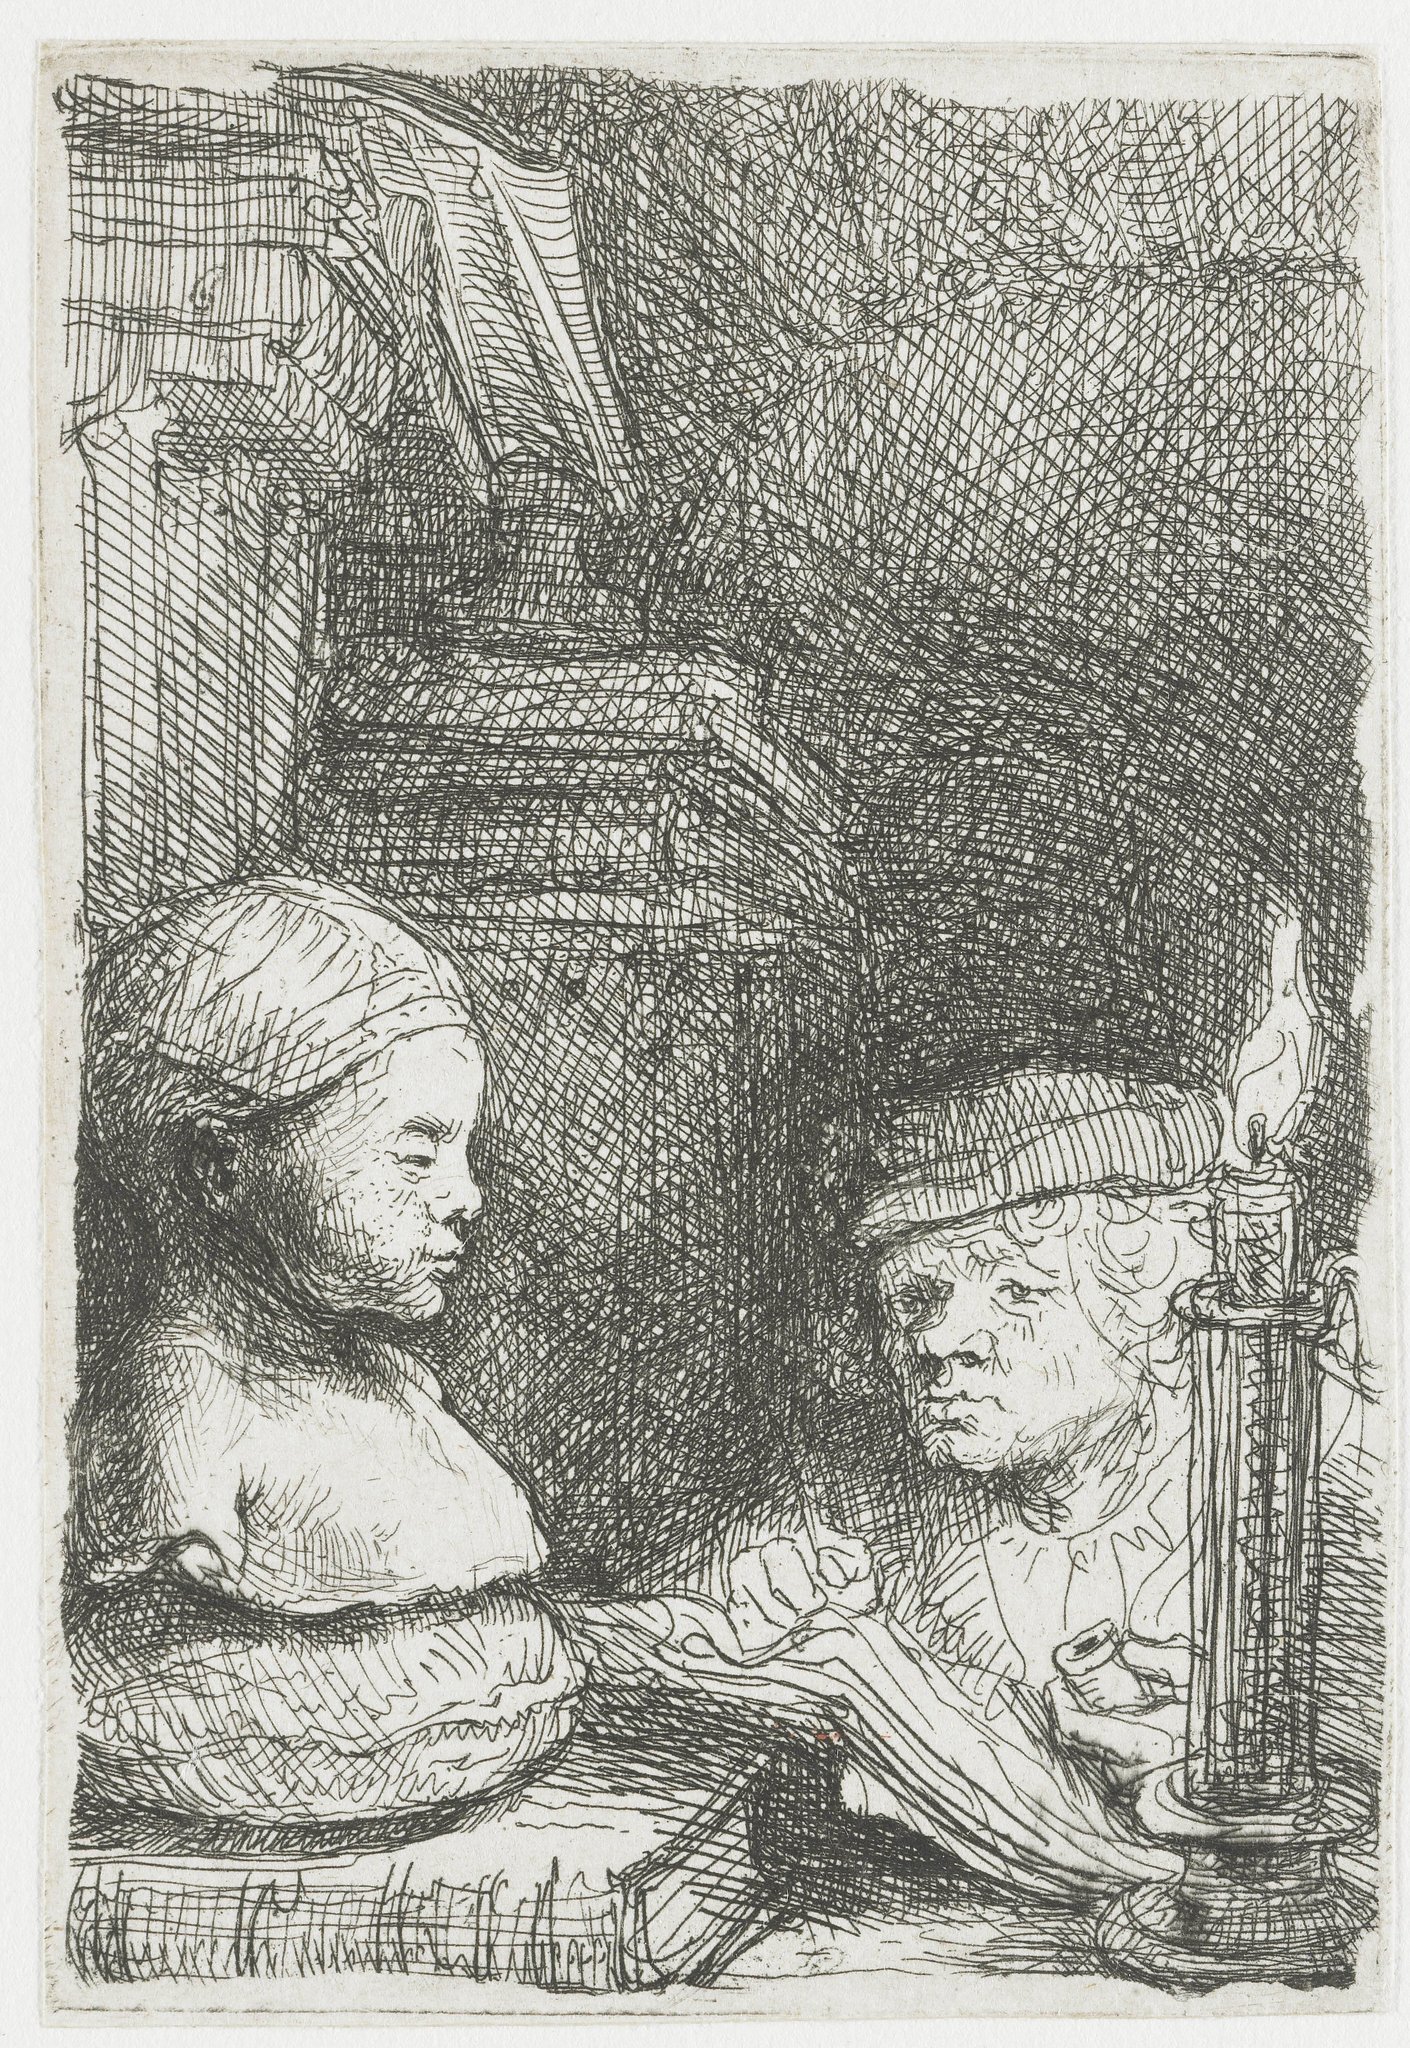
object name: print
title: Man Drawing from a Plaster Cast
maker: rembrandt van rijn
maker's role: draughtsman, painter, print maker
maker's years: 1606-1669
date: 1641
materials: paper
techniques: etching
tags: drawing, art (+ artist studying classical remains)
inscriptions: collector's mark: Lugt 240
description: A young man with weary eyes is seated at a table drawing a plaster cast of a woman by candlelight. The bust rests on a cushion, which in turn lies on a book. Learning how to draw inanimate three-dimensional objects was a phase in the training of pupils before they were allowed to draw from live models.